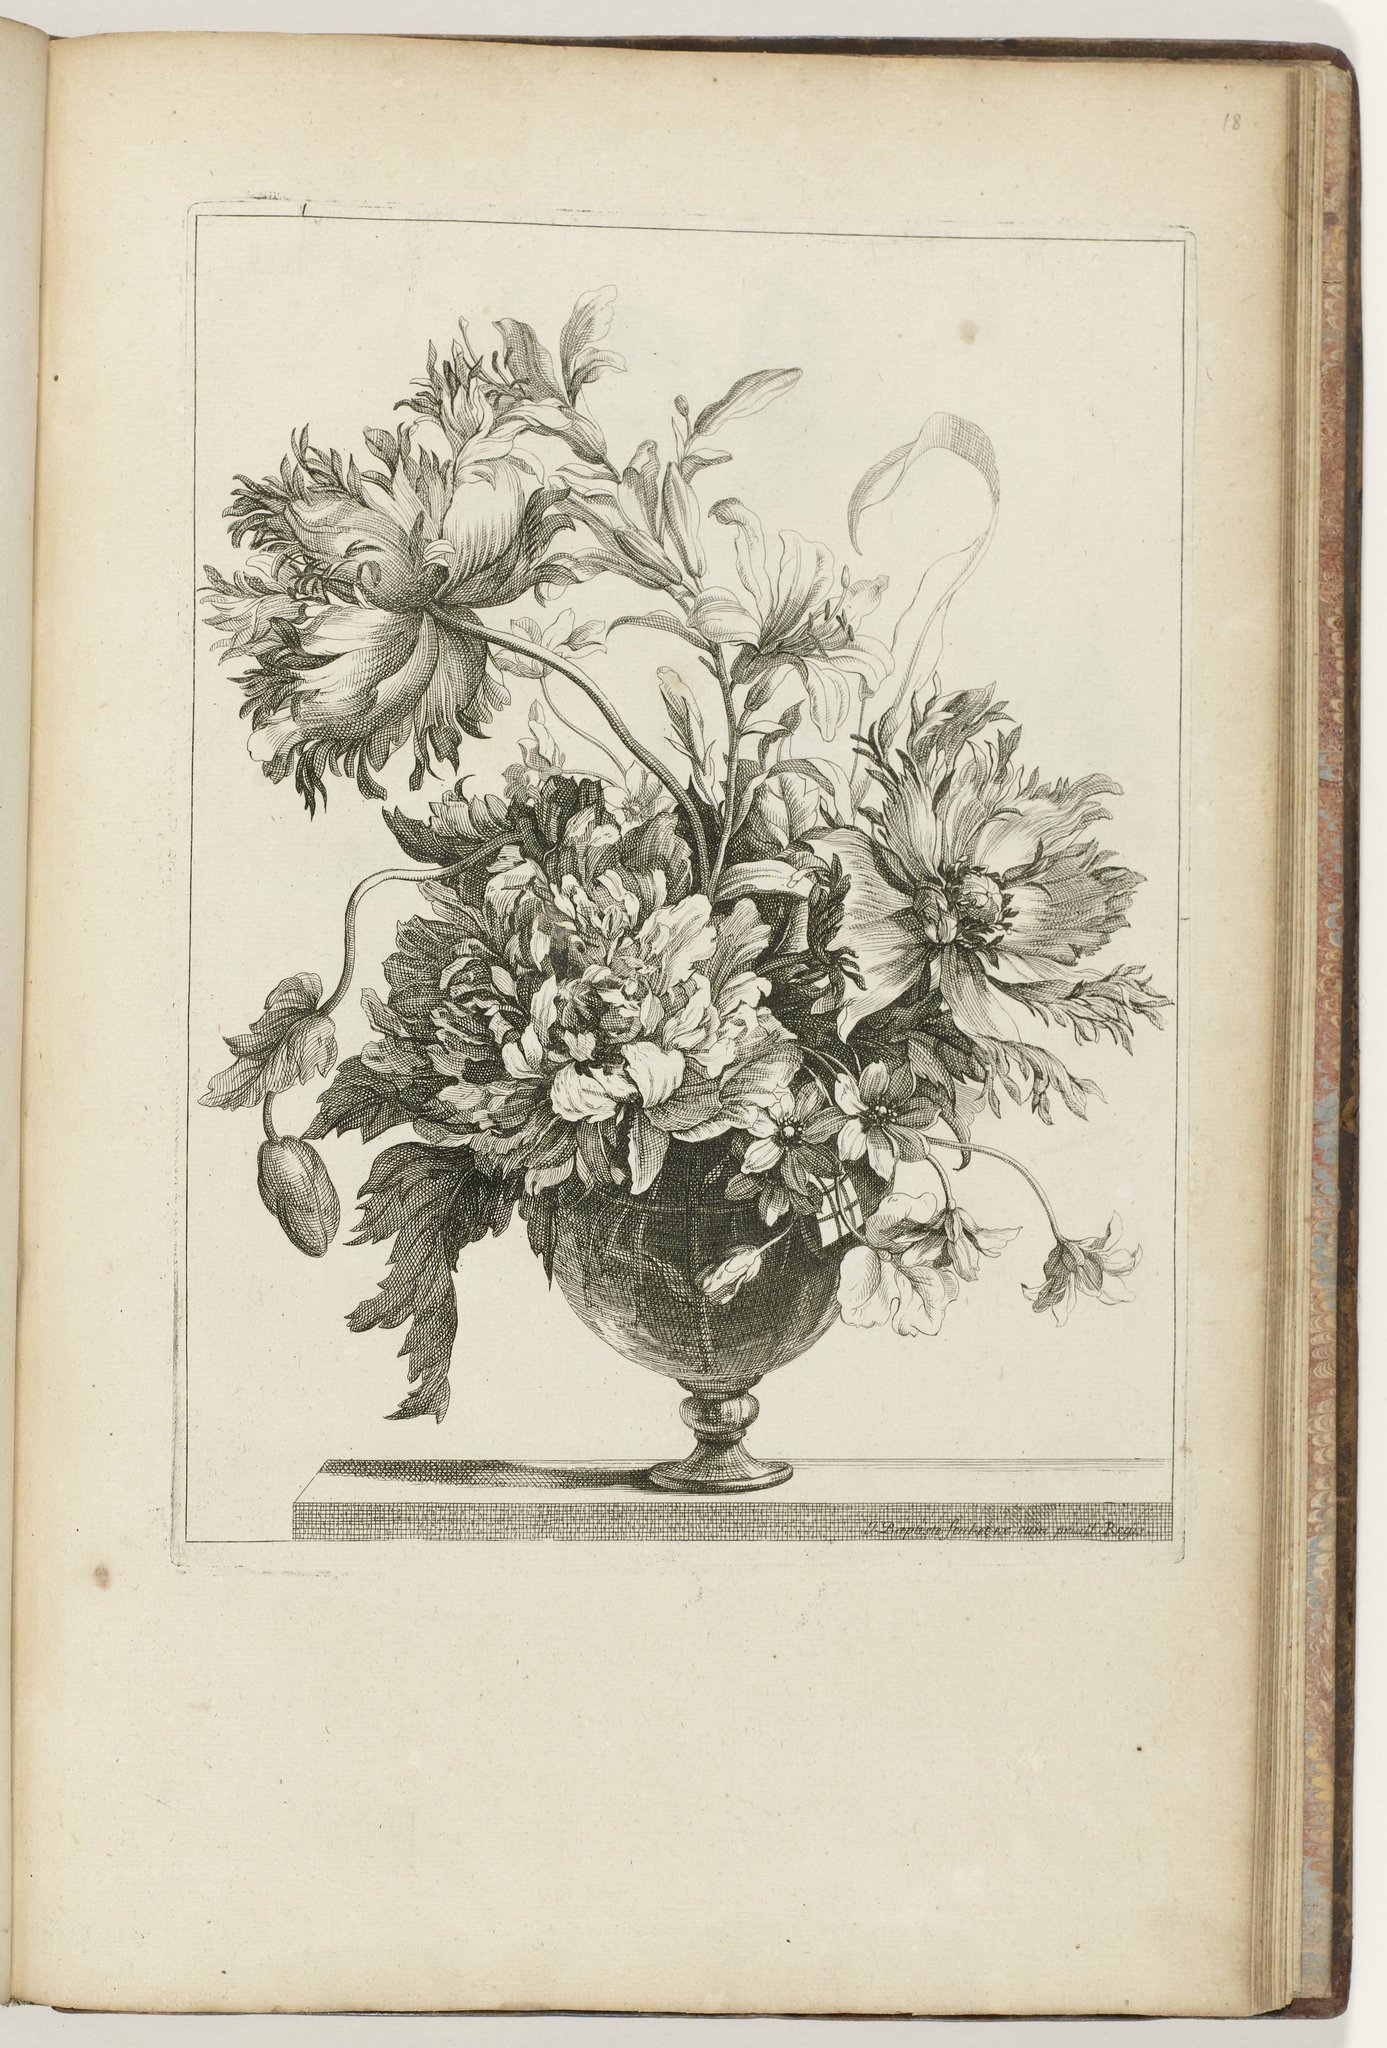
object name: album leaf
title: Boeket in glazen vaas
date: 1680-1695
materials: paper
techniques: etching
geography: paris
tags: flowers in a vase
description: Boeket in glazen vaas. Prent maakt deel uit van een album.